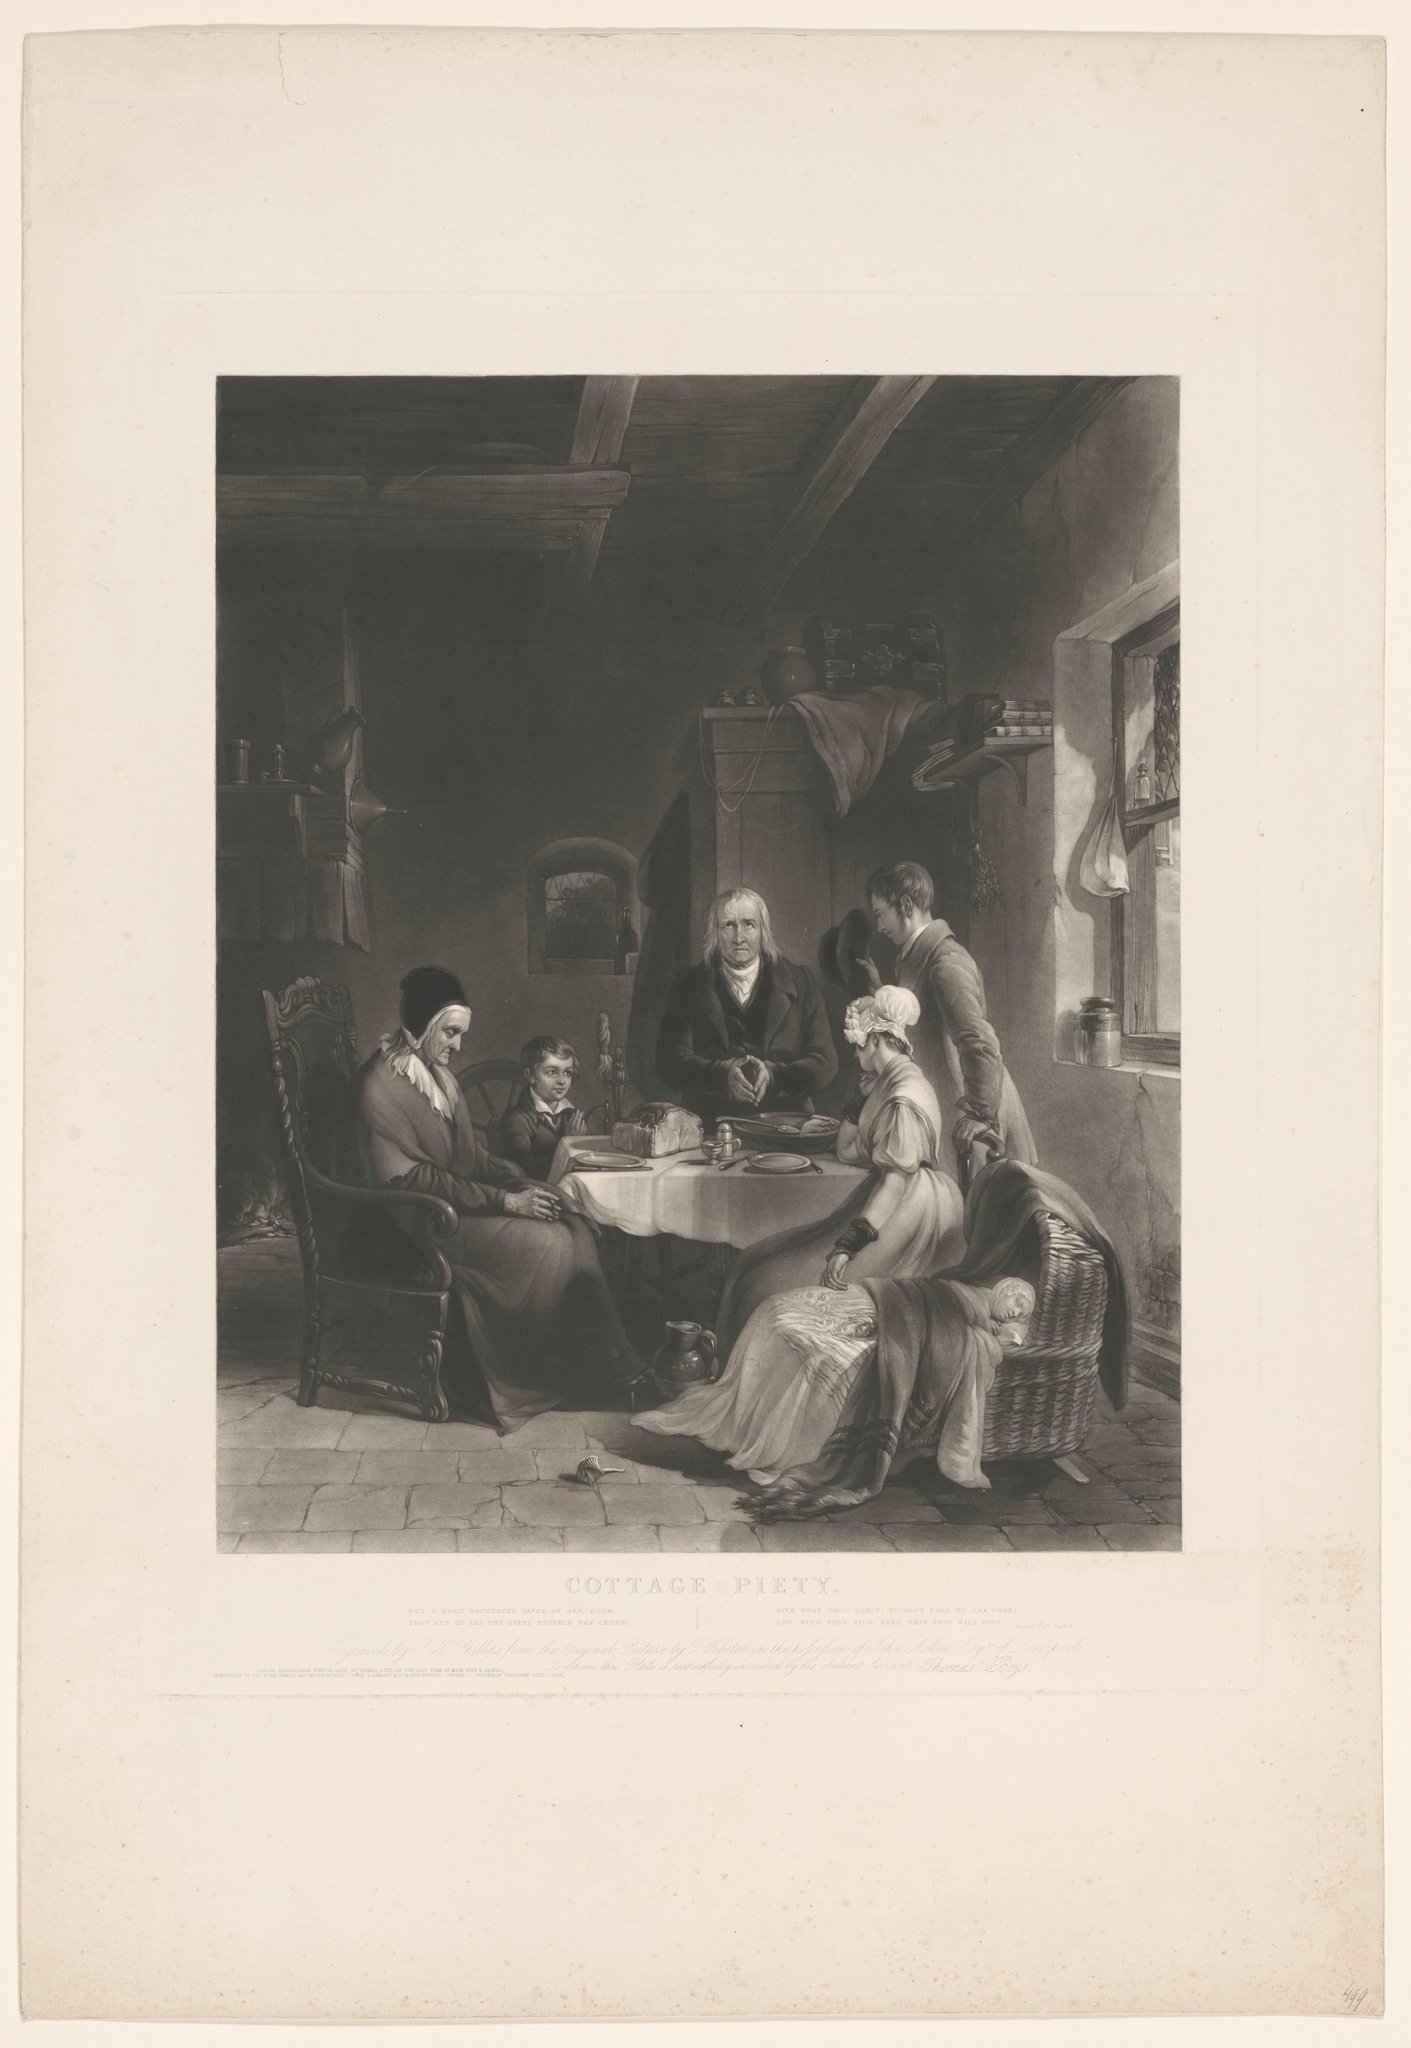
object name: print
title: Gezin bidt voor de maaltijd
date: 1853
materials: paper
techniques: mezzotint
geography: london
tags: evening meal, dinner, supper, one person praying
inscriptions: collector's mark: Lugt 2228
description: Prent voor het eerst gepubliceerd op 1 oktober 1836.